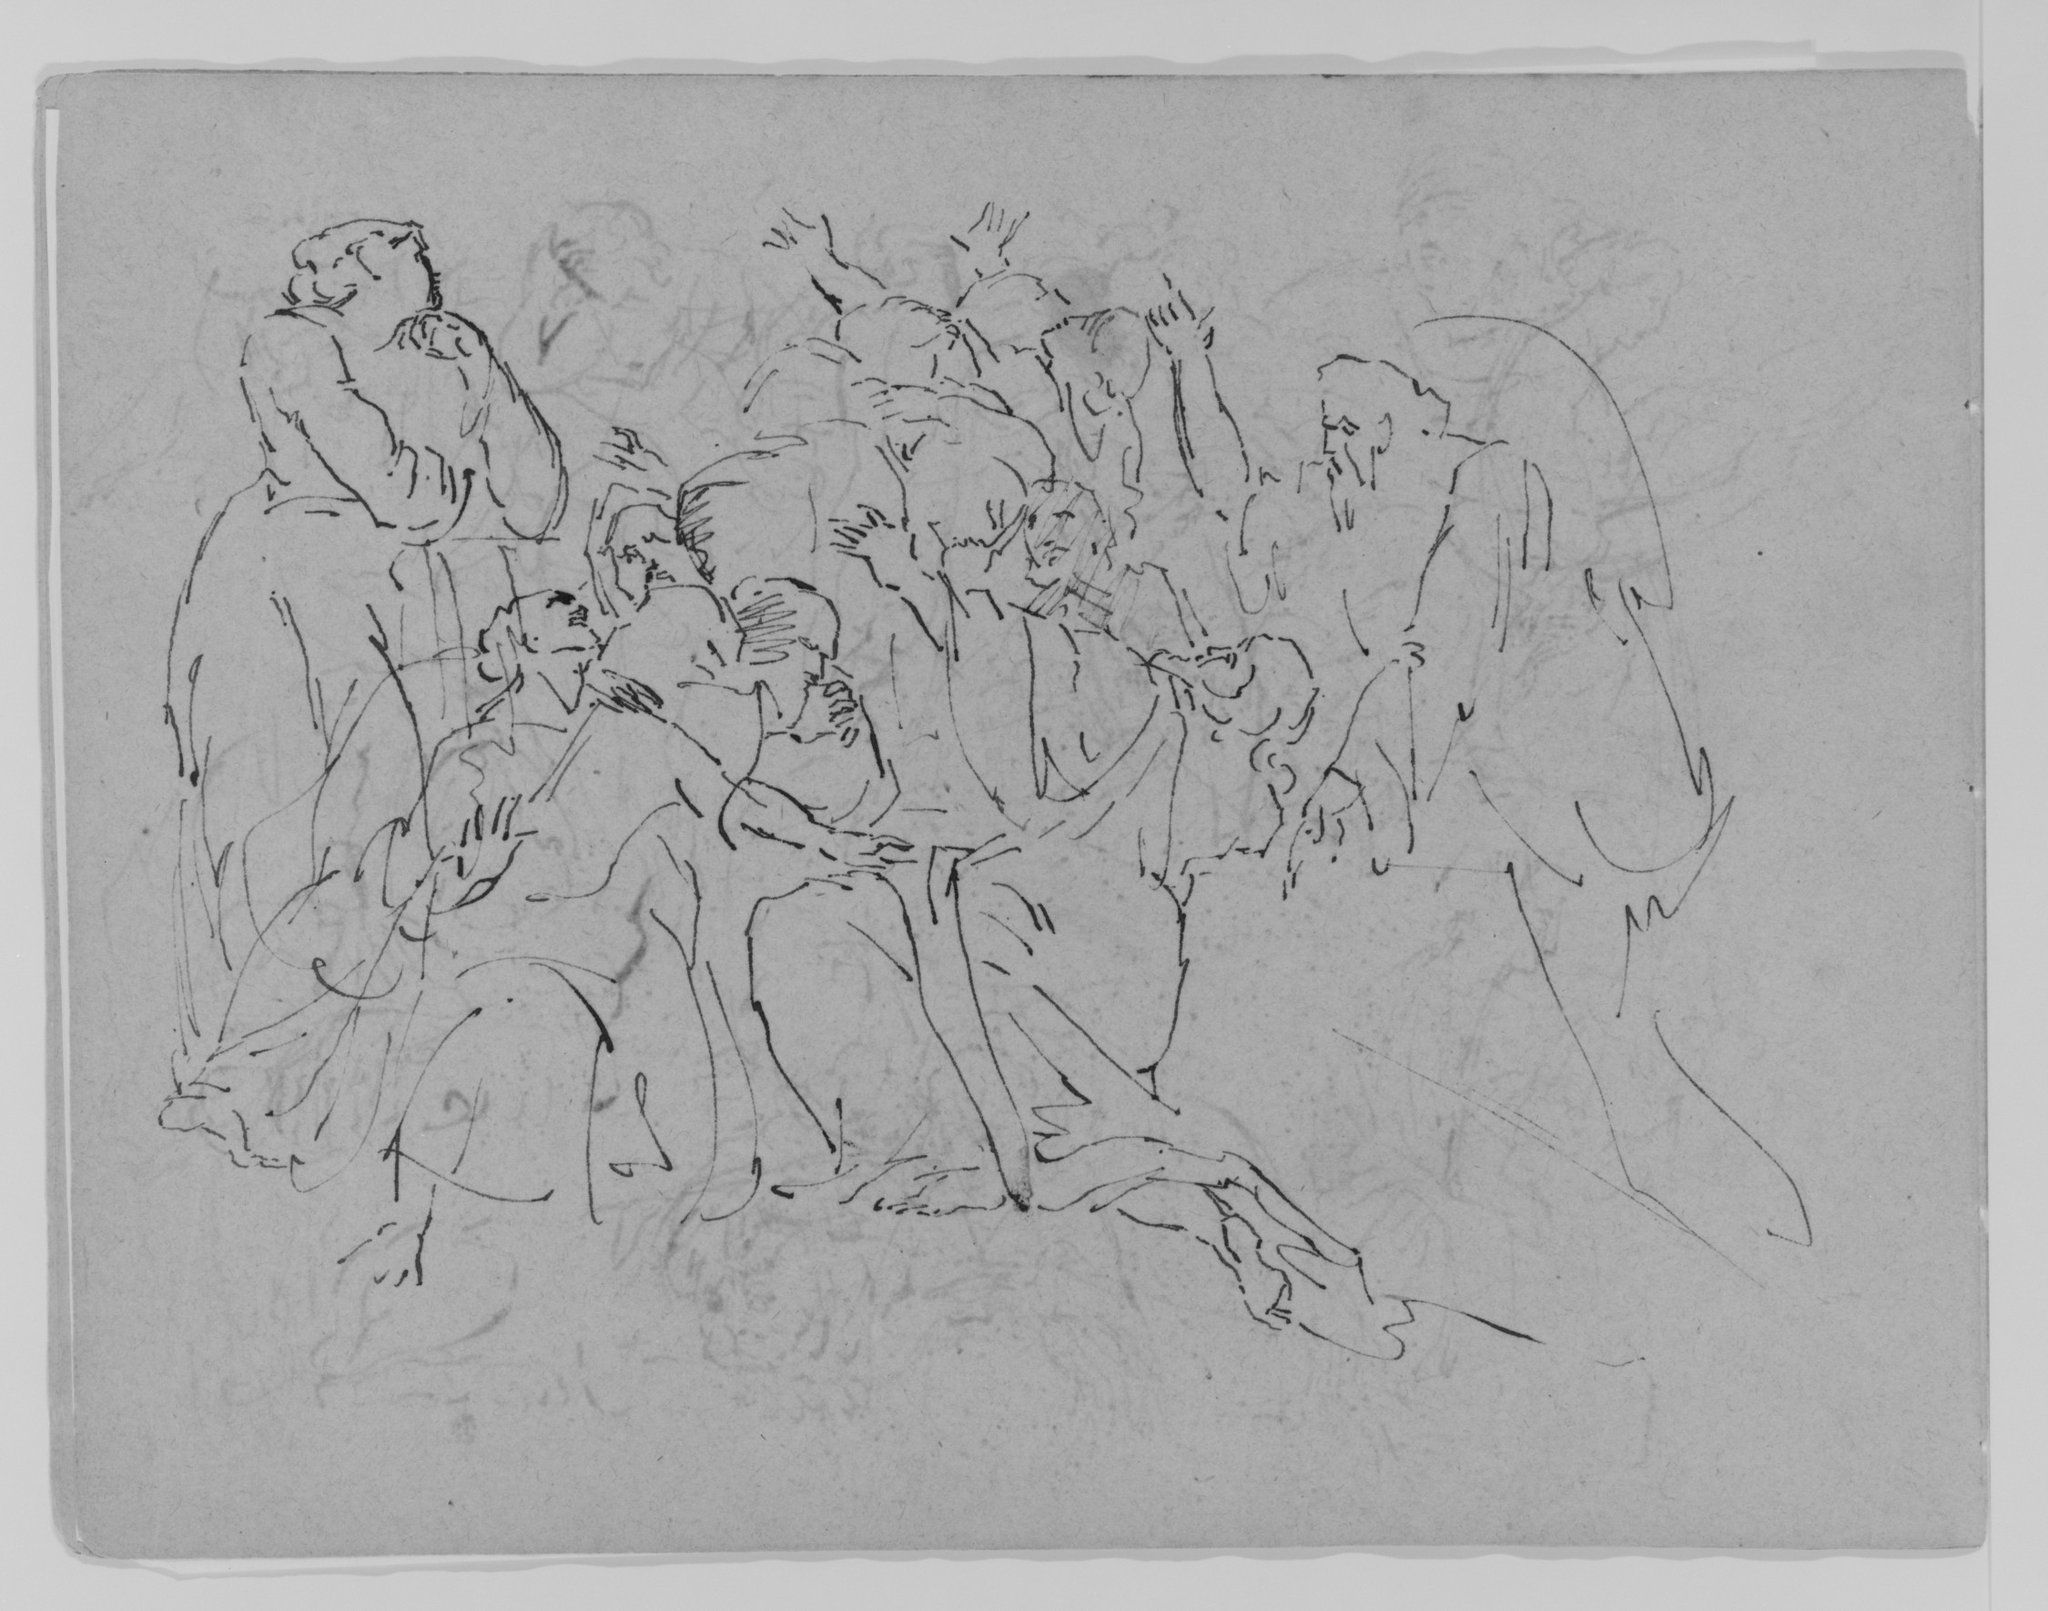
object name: drawing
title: (From Sketchbook)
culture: american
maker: thomas sully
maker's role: artist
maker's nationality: american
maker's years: 1783-1872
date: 1810-1820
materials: ink, paper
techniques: wash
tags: men,women